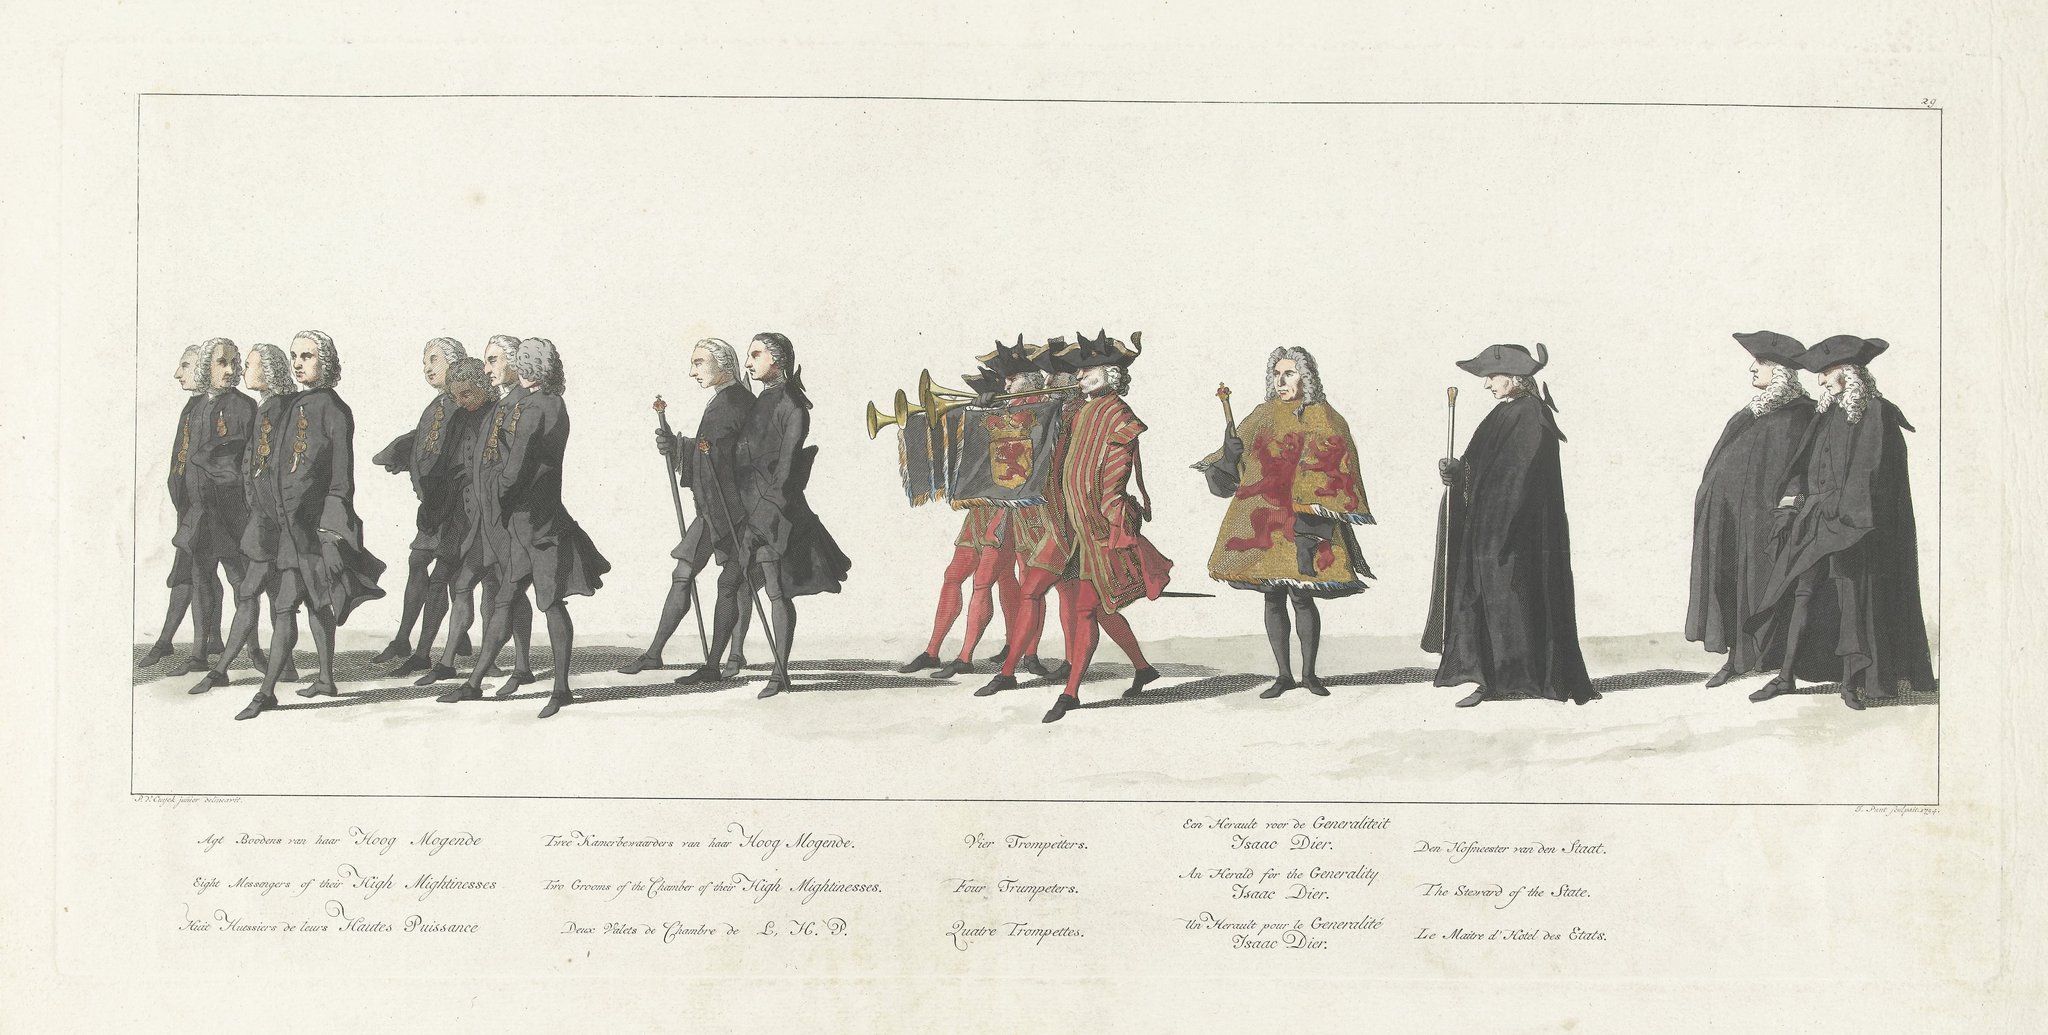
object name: print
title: Lijkstatie van Willem IV, 1752, plaat 29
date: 1754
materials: paper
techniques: engraving, etching, hand coloring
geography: northern netherlands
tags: willem iv (prins van oranje-nassau), military music, cortege, funeral procession, delft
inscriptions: collector's mark: Lugt 2228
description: Leden van de staf van de Staten-Generaal, met vier trompetters. In de marge het onderschrift in Nederlands, Frans en Duits. Onderdeel van een serie van 41 platen van de begrafenisstoet van stadhouder Willem IV te Delft op 4 februari 1752. Genummerd rechtsboven: 29.